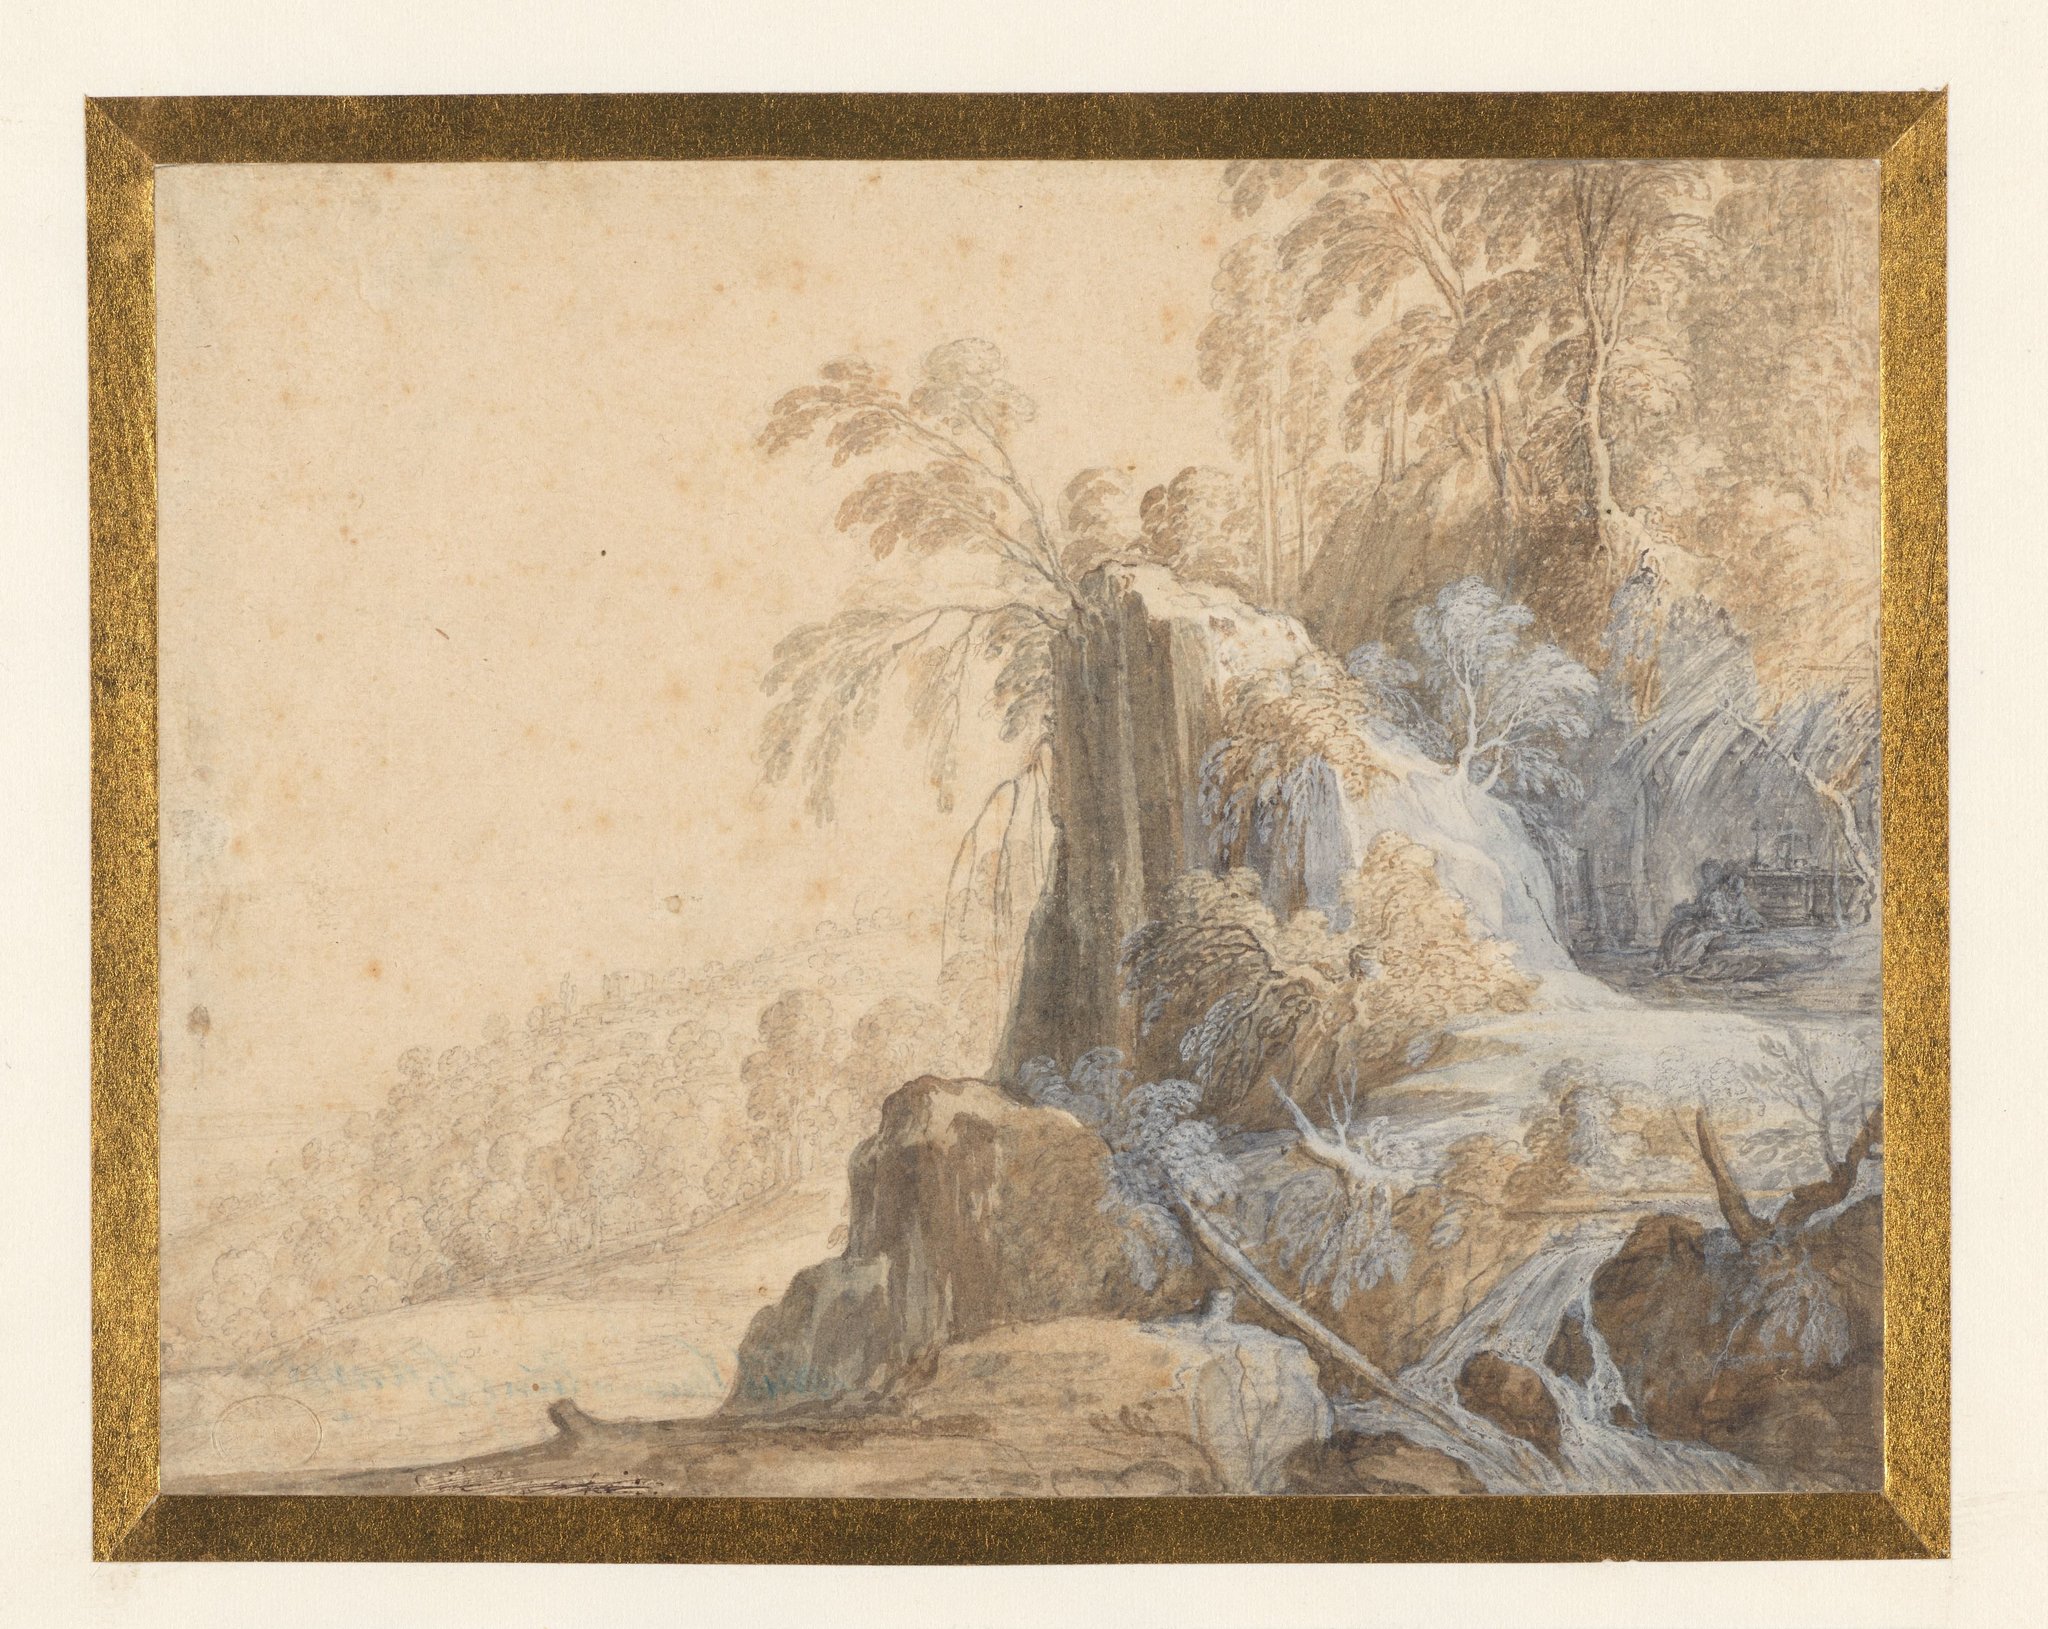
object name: drawing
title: Landschap met een kluizenaar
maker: alexander keirincx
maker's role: draughtsman, painter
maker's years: 1600-1652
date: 1610-1652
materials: paint, graphite, ink, paper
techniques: brush, pen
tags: st. jerome as hermit in a landscape, reading, anchorite, hermit, mountains